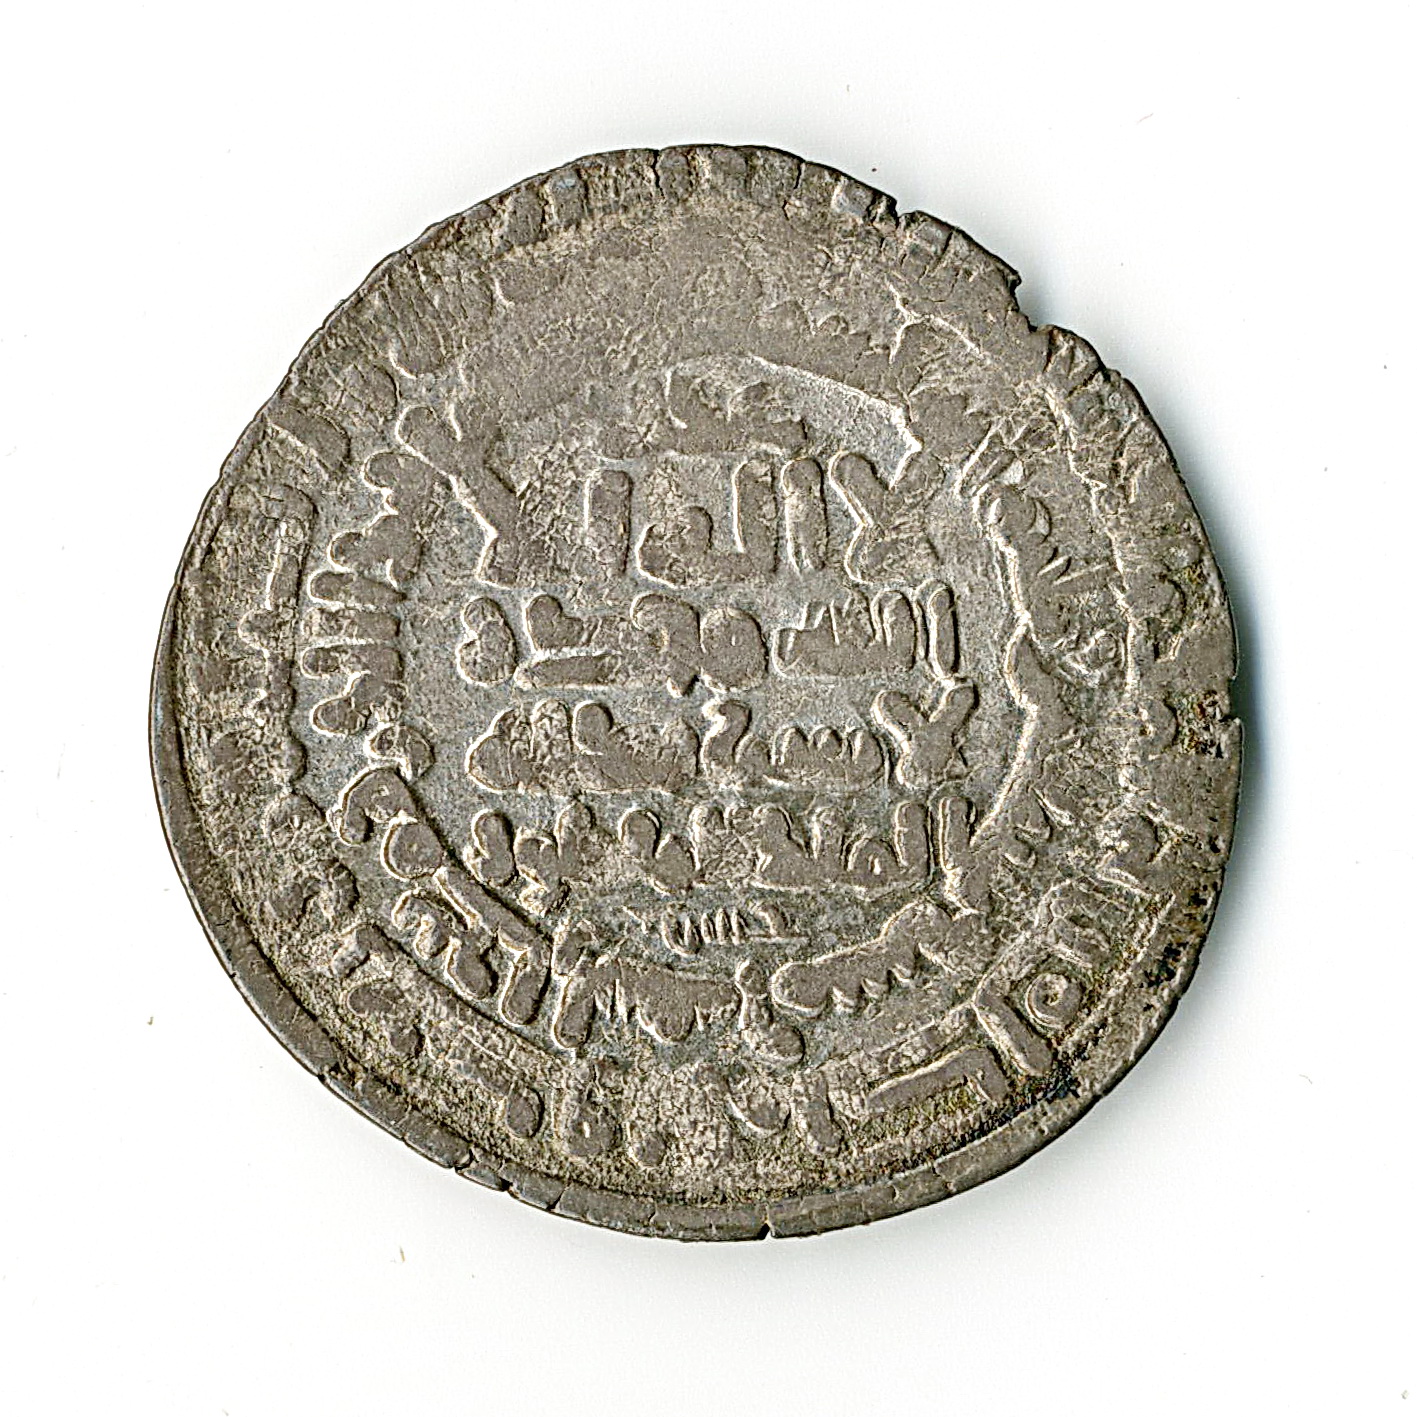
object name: coin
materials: silver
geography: uzbekistan